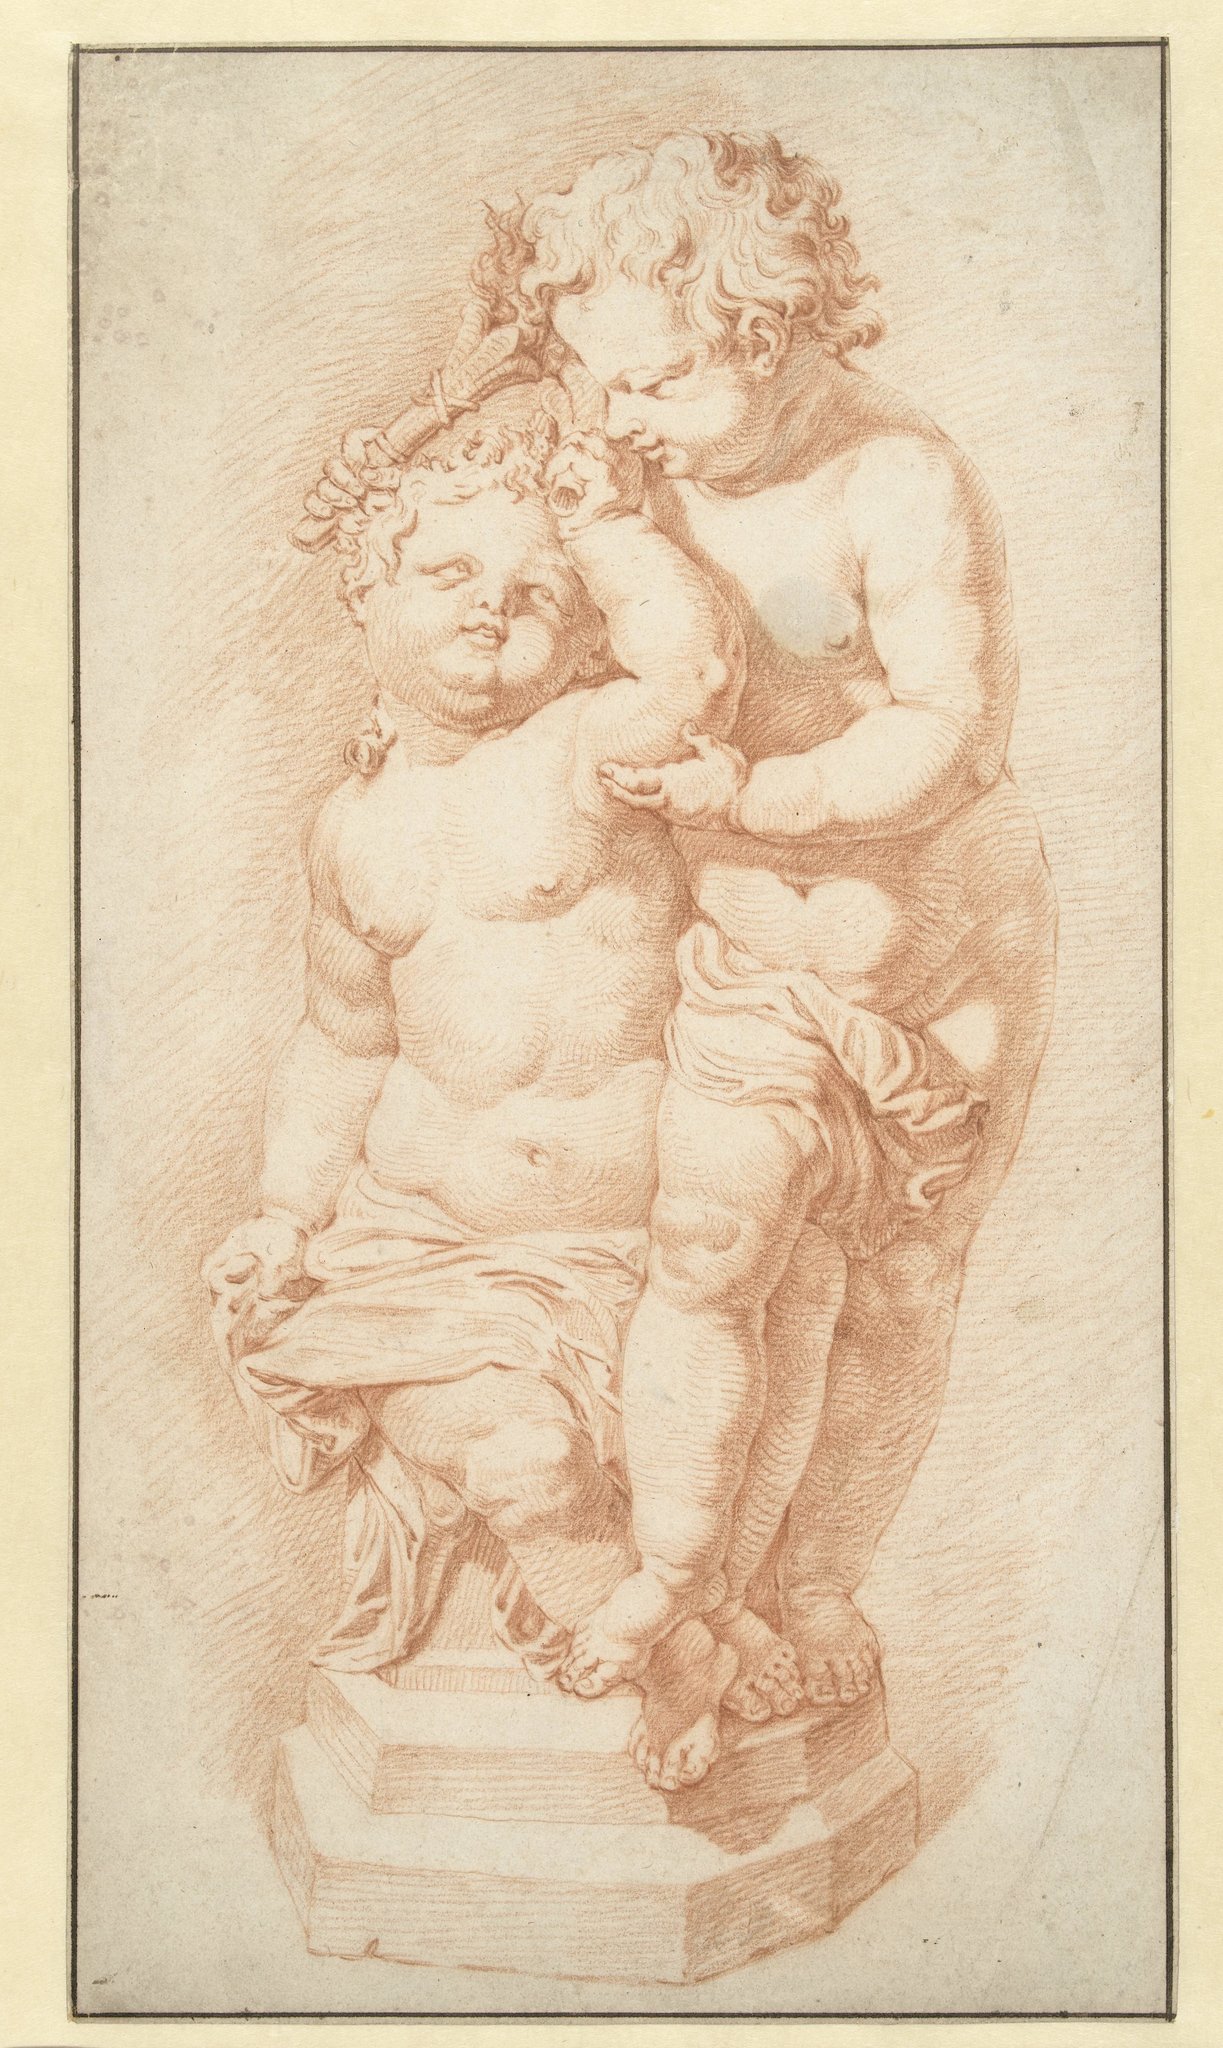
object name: drawing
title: Standbeeld van twee putti met een fakkel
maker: Anonymous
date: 1600-1699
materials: chalk, paper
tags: torch, piece of sculpture, reproduction of a piece of sculpture, cupids: 'amores', 'amoretti', 'putti'